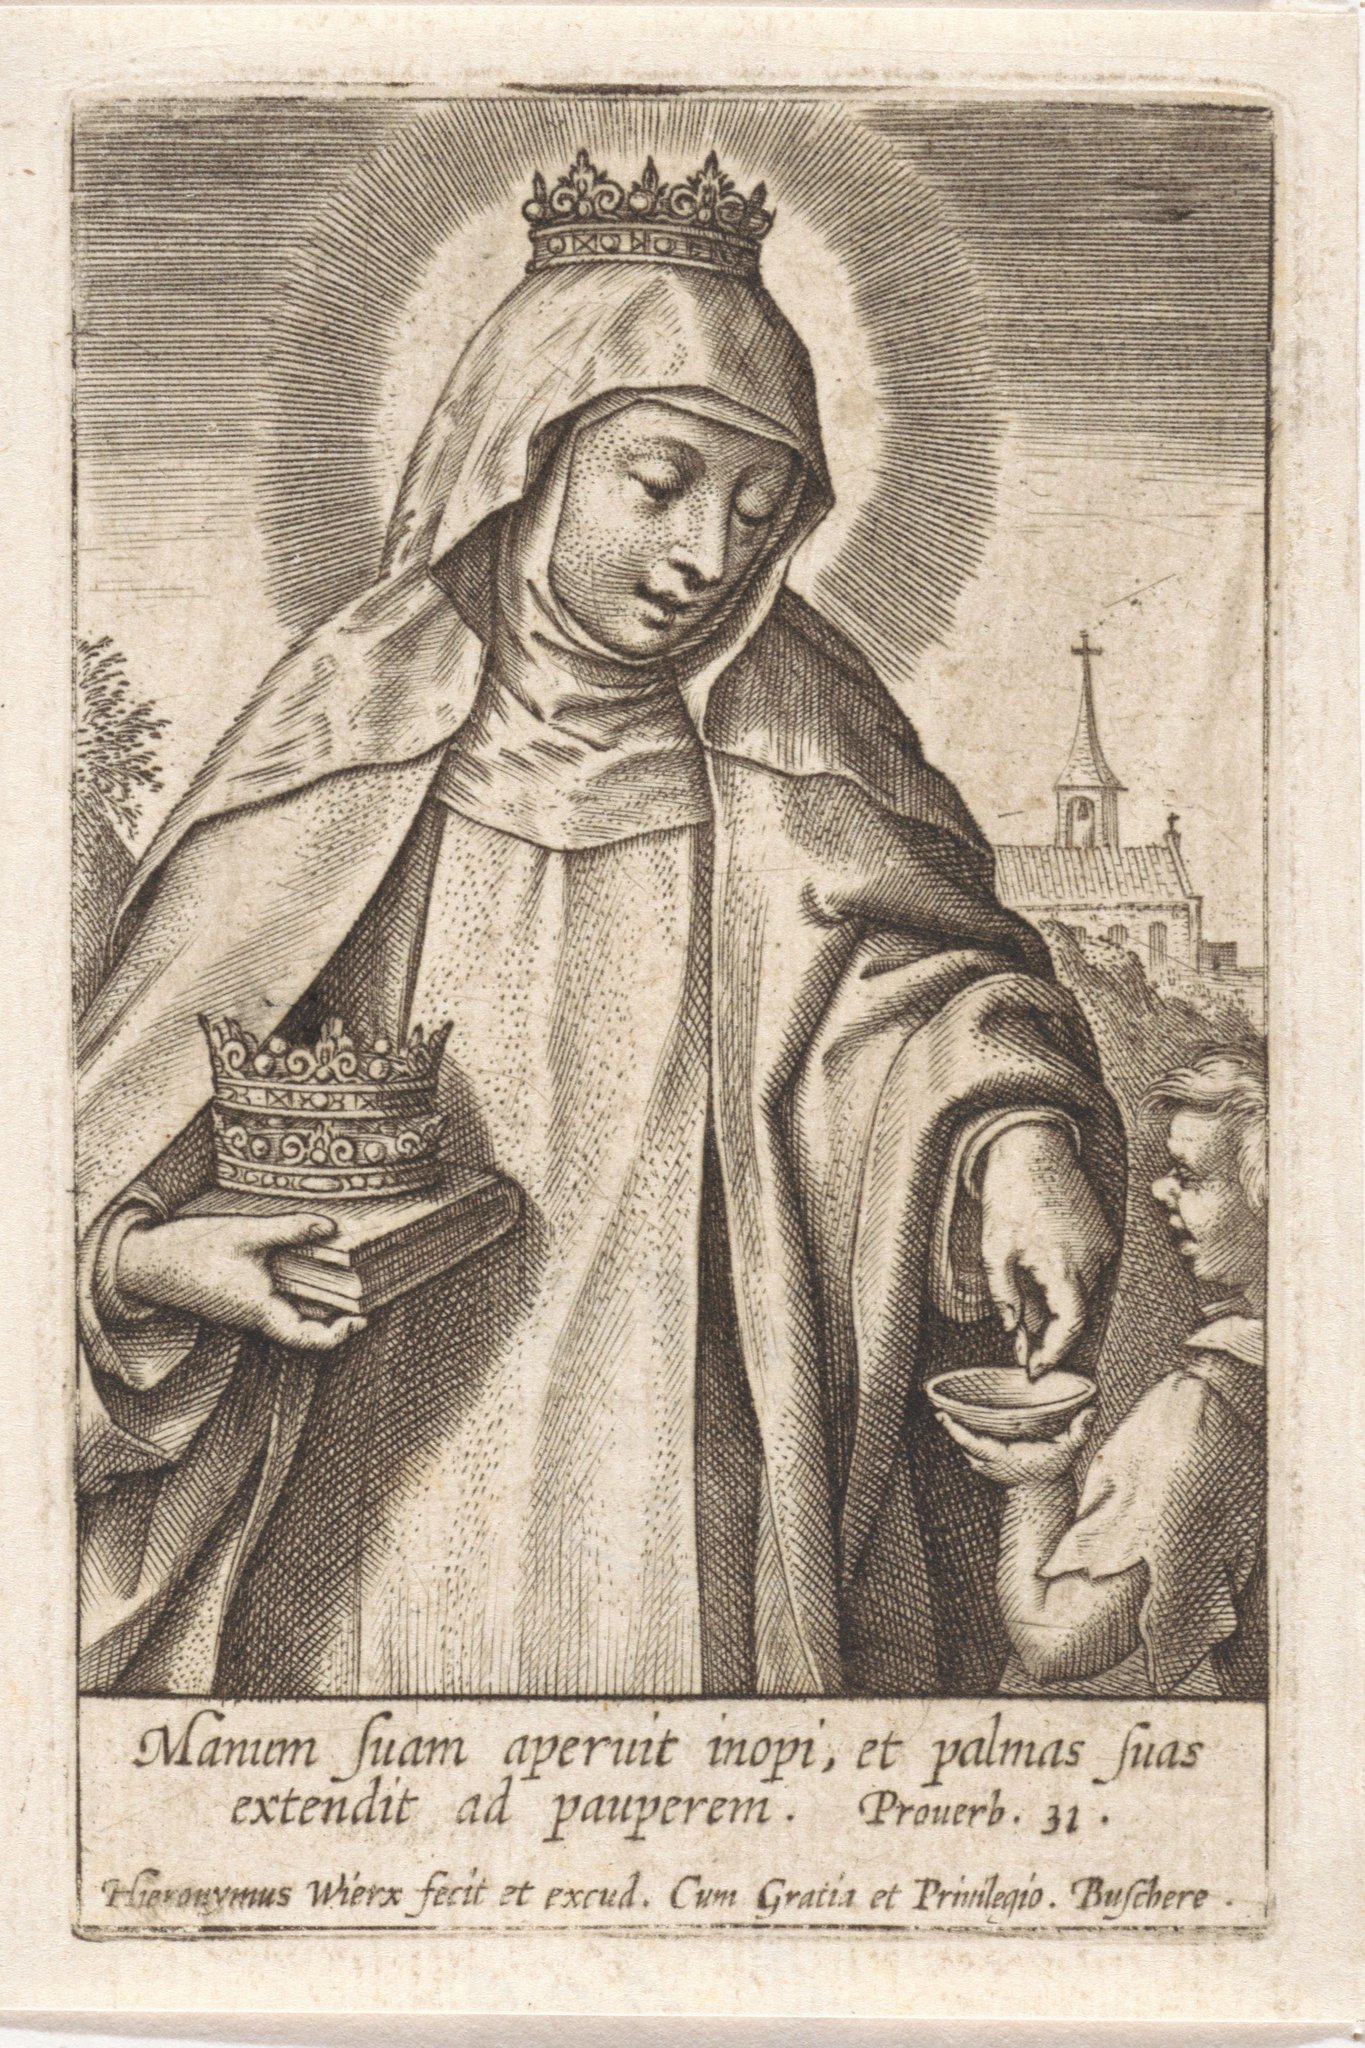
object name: print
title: H. Elisabet van Hongarije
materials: paper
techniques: engraving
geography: antwerp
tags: st. elisabeth giving alms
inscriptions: collector's mark: Lugt 2228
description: De heilige Elisabet van Hongarije, gekleed als franciscaner non. Ze is gekroond en in haar hand houdt ze een boek waar nog twee kronen op liggen. Ze geeft een munt aan een bedelend kind. Rechts op de achtergrond een gezicht op een kerk. In de marge een tweeregelig Bijbelcitaat uit Spr. 31 in het Latijn.